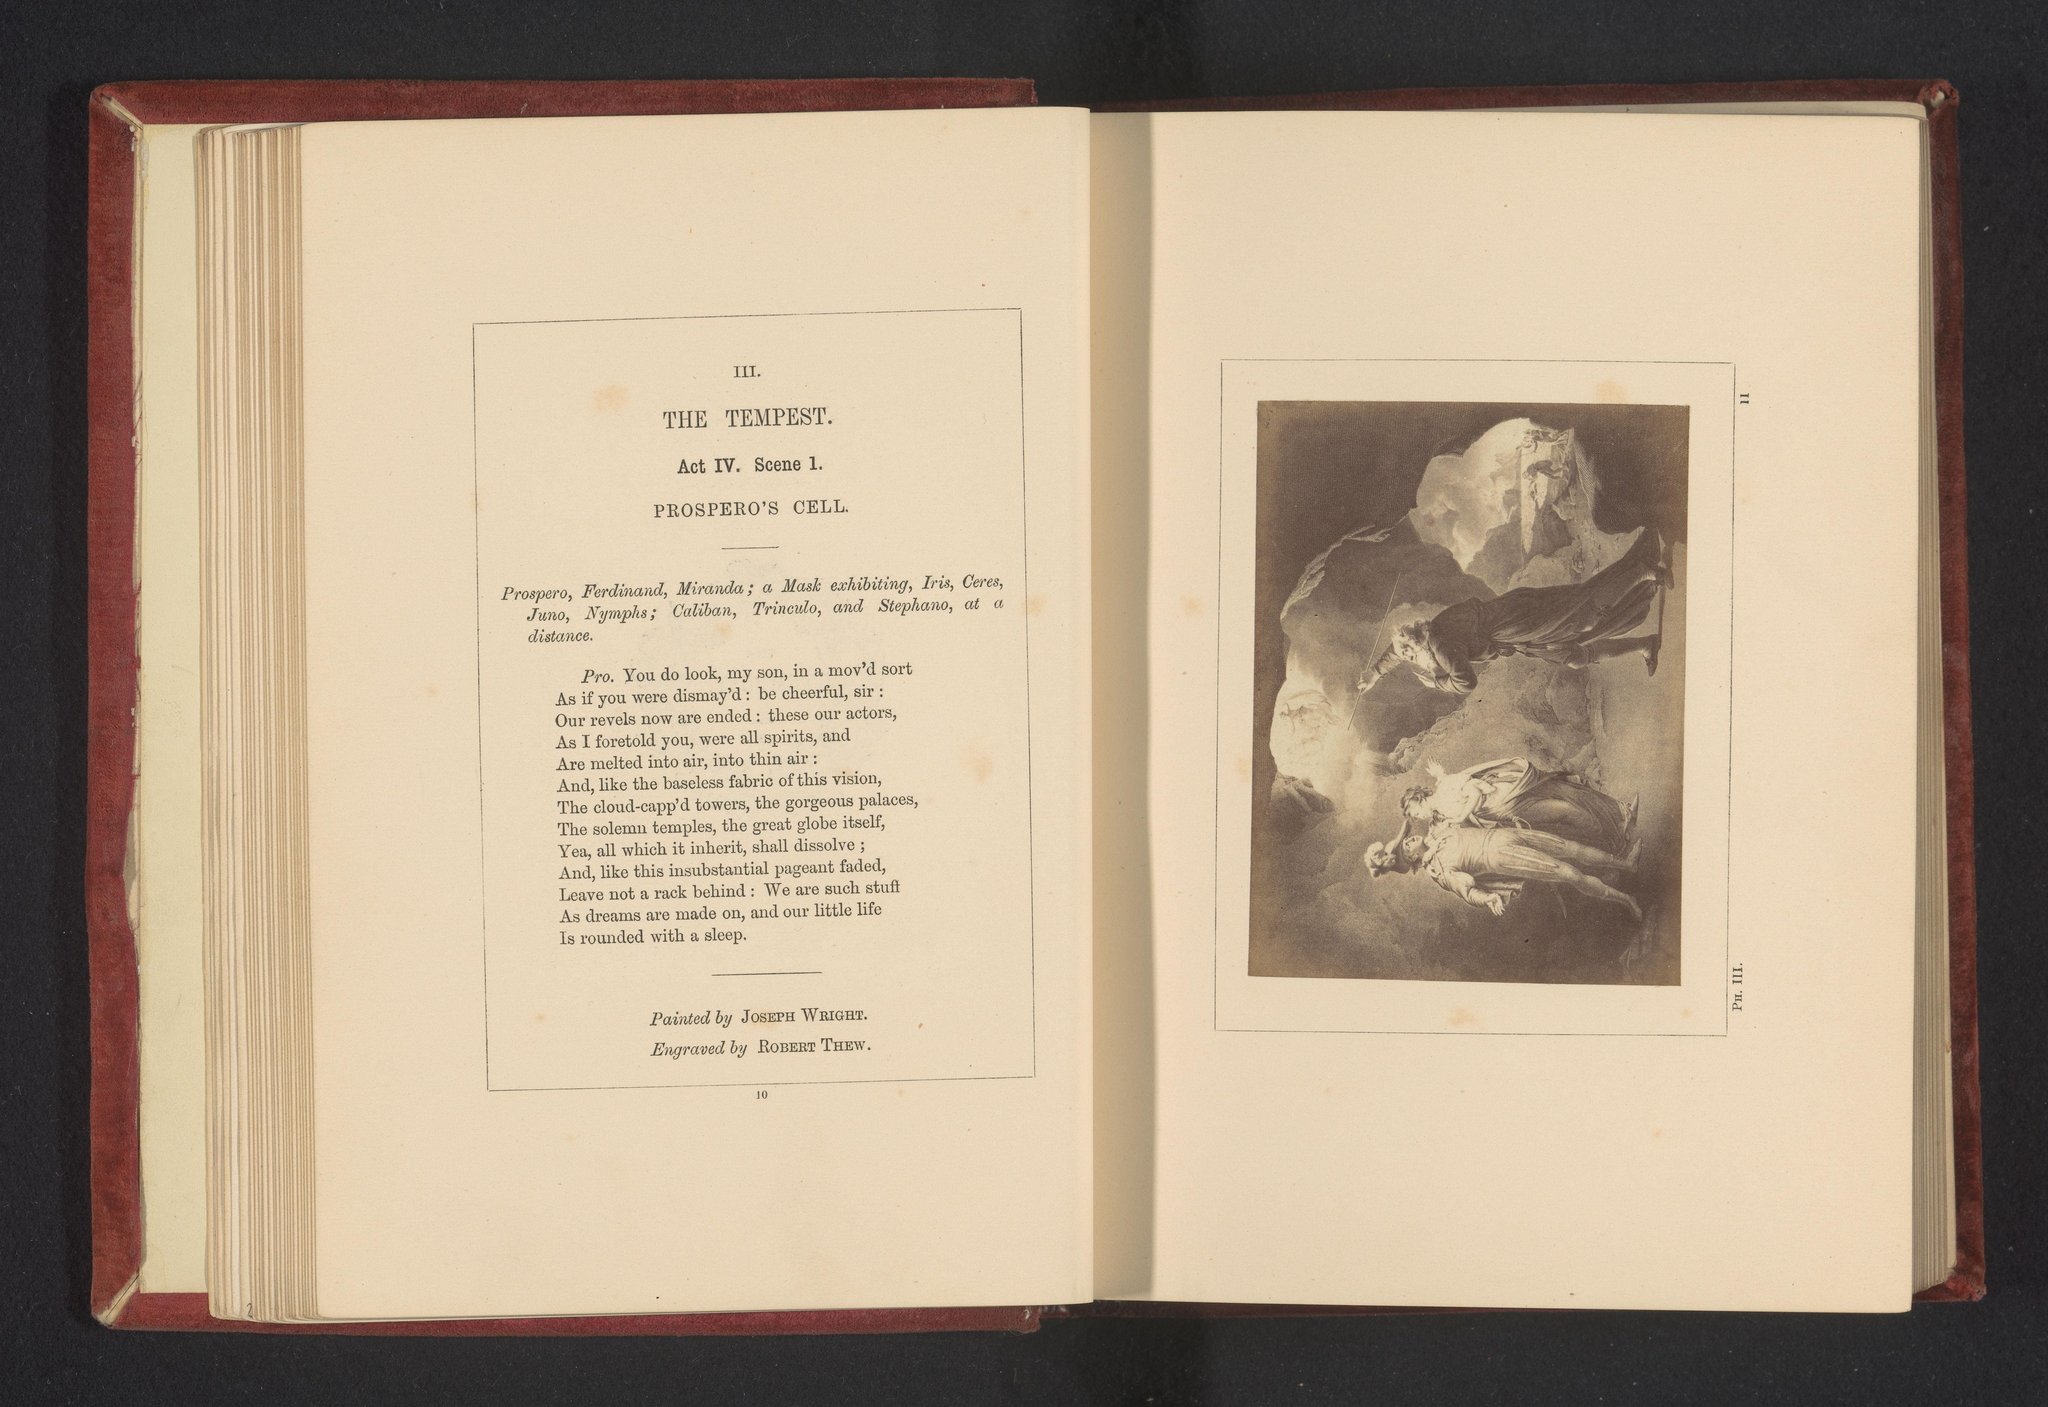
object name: reproduction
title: Fotoreproductie van een prent naar een schilderij door Joseph Wright, voorstellend een scene uit De Storm door William Shakespeare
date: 1854-1864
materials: photographic support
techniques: albumen print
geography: london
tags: (scenes from) specific works of literature: shakespeare, tempest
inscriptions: number: ‘Ph. III. 11’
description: Te zien is akte IV, scene 1: Links staan Ferdinand en Miranda, rechts staat de magiër Prospero.